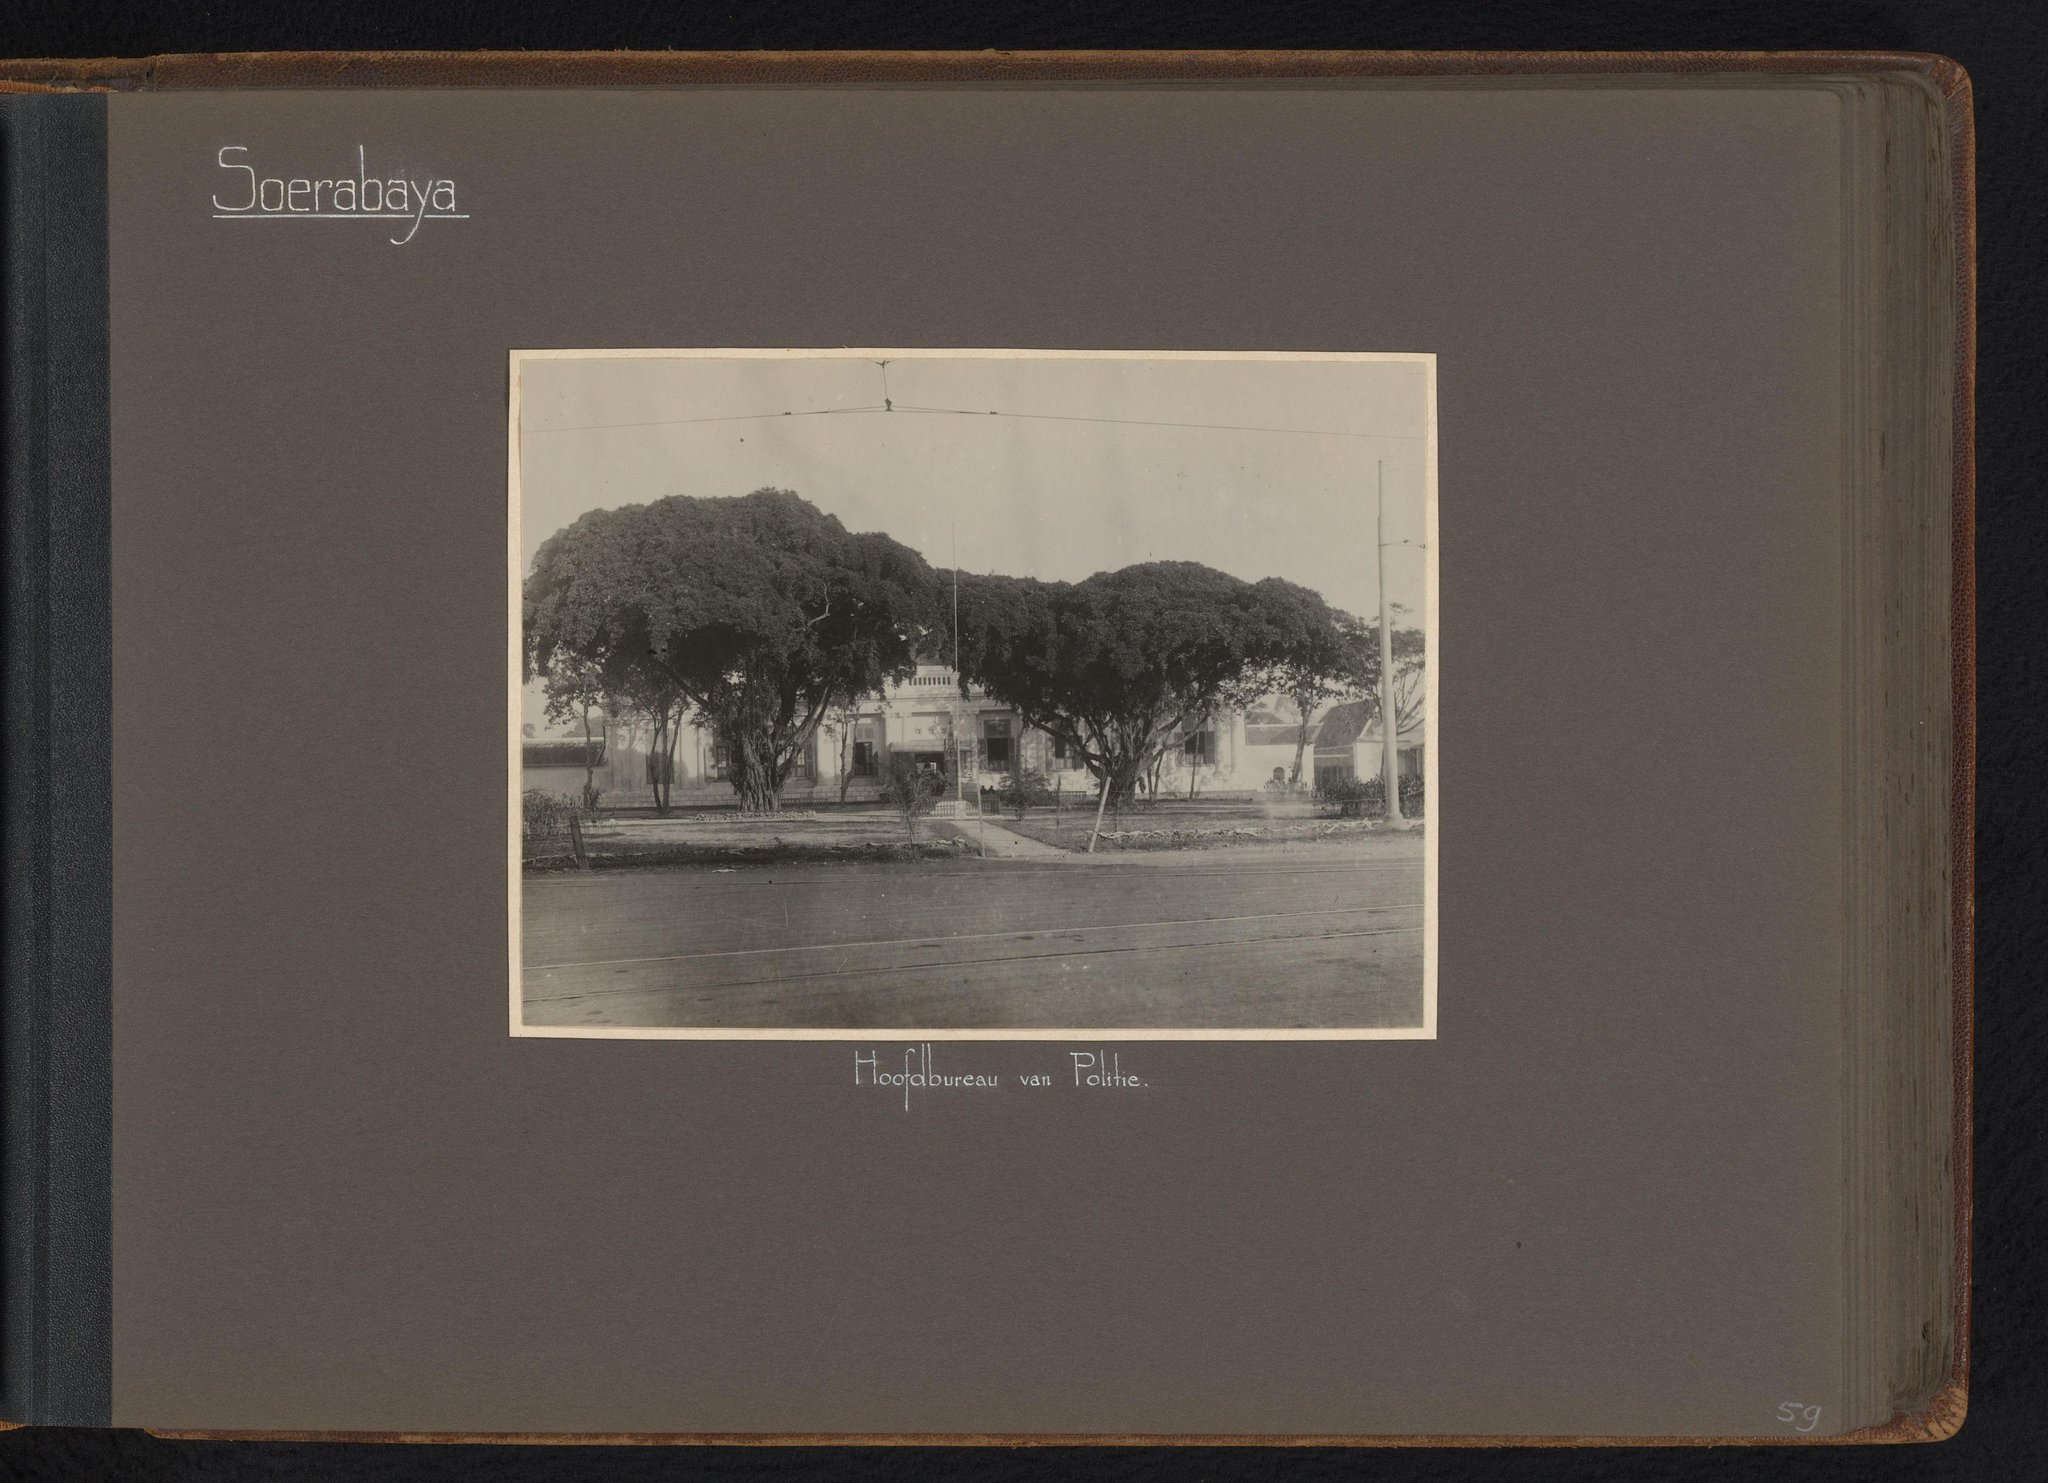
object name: photograph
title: Soerabaya / Hoofdbureau van Politie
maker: Anonymous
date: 1925-1931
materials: cardboard, photographic support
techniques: gelatin silver print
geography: surabaya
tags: surabaya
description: Albumblad met één foto: het hoofdbureau van politie te Soerabaja. Onderdeel van het fotoalbum aangeboden aan S. Koster door de Vereeniging van Hoogere Politie Ambtenaren in Nederlandsch-Indië in 1931.